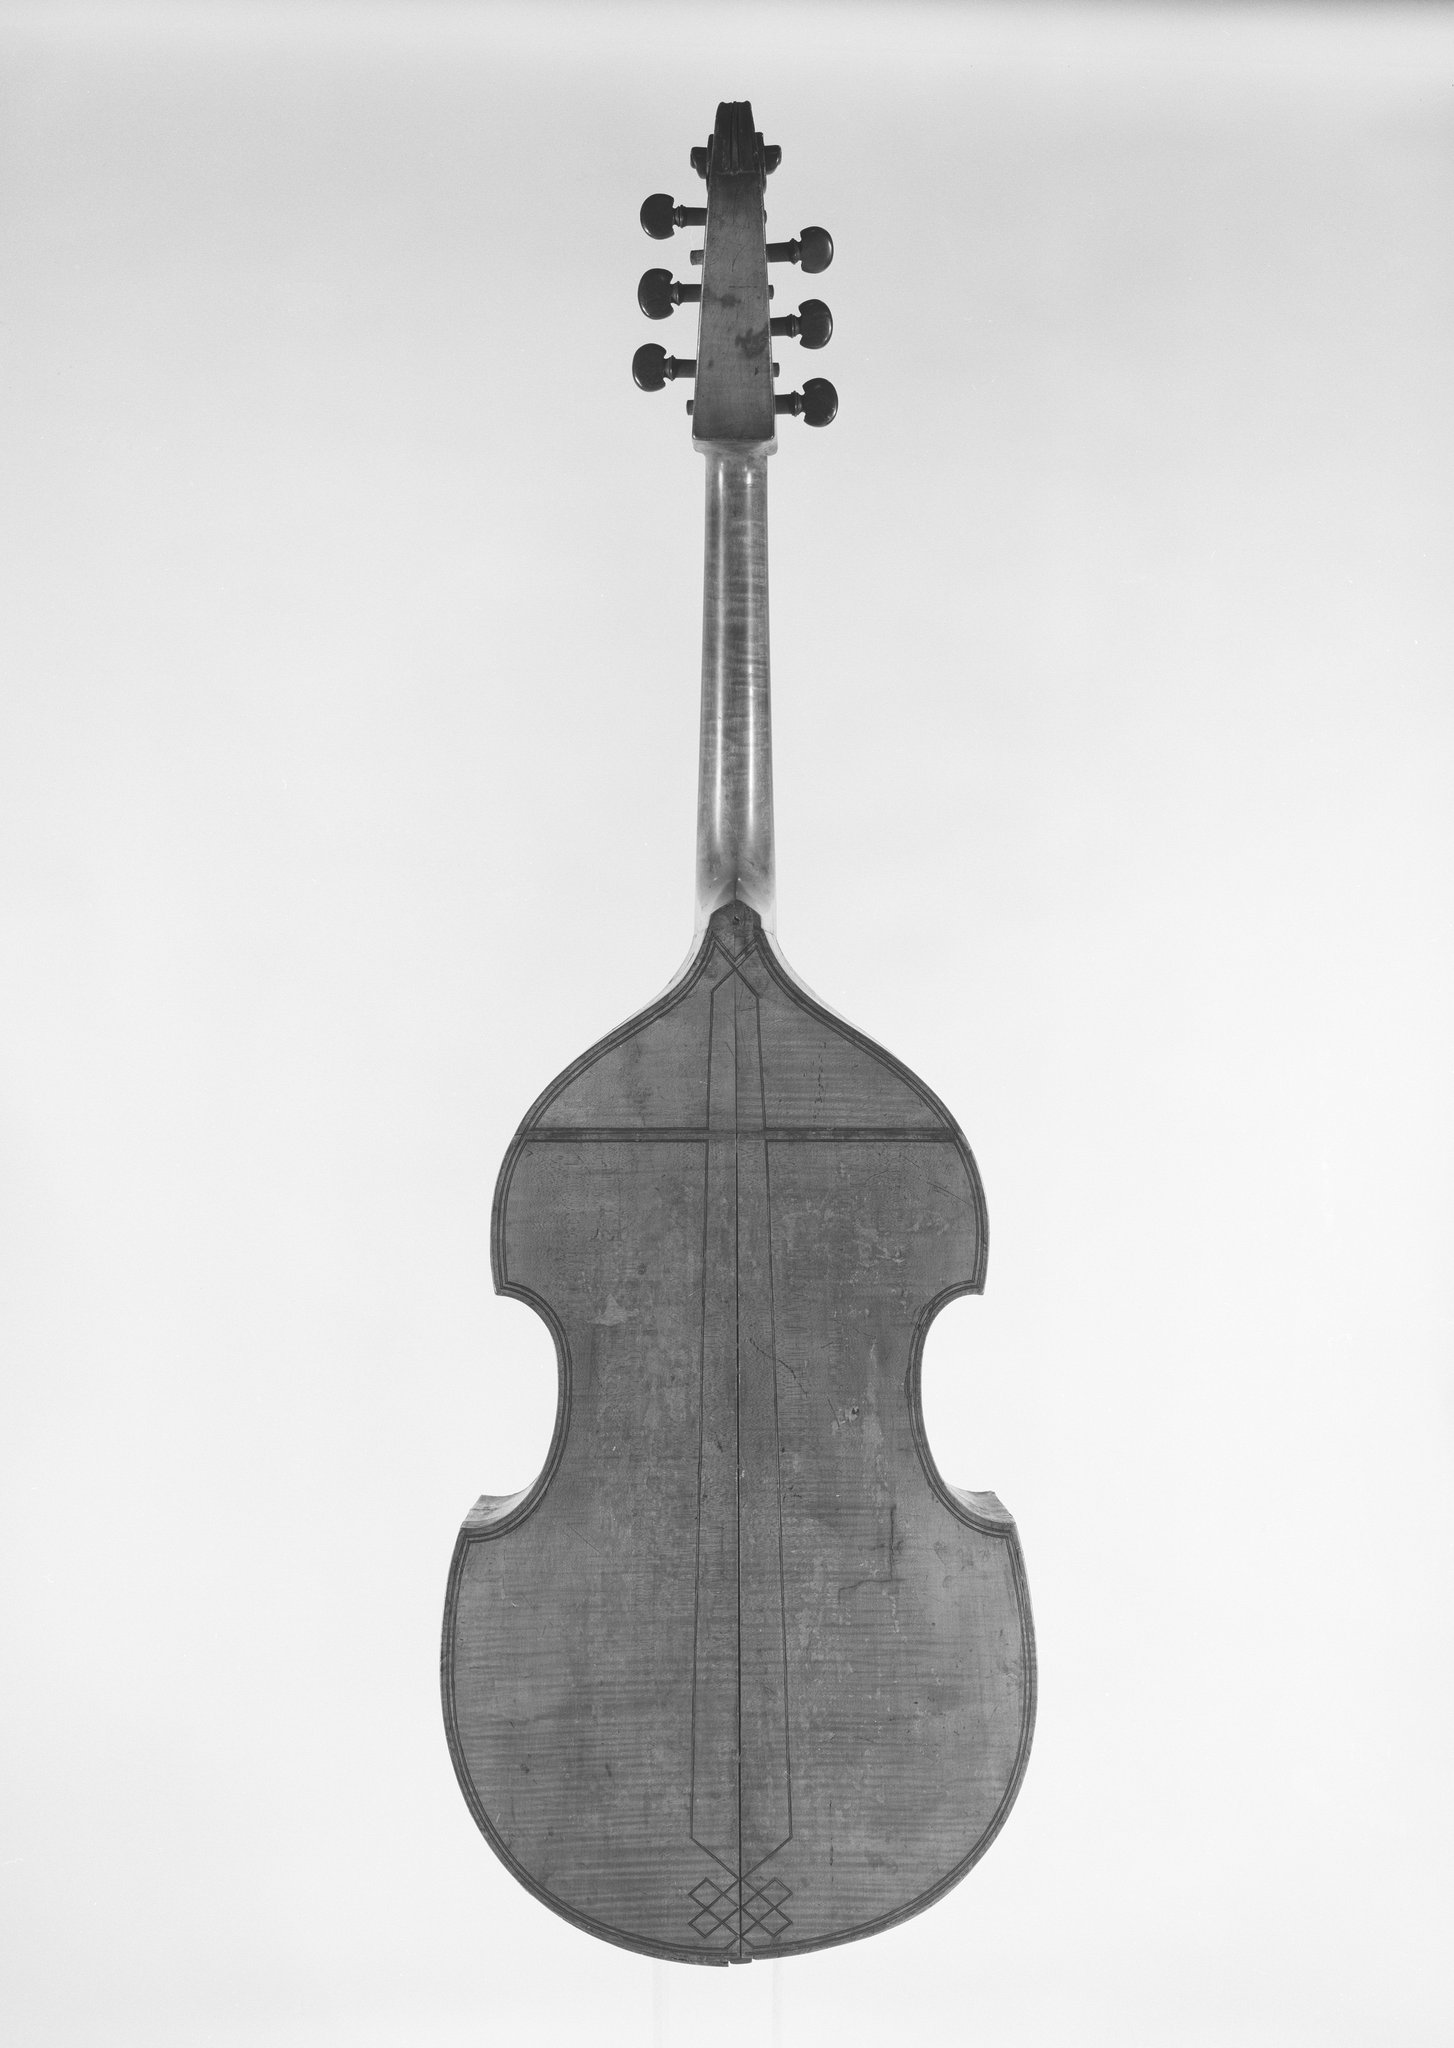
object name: division viol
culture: british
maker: henry smith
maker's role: maker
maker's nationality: british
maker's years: 1623-1637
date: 1629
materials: wood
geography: united kingdom